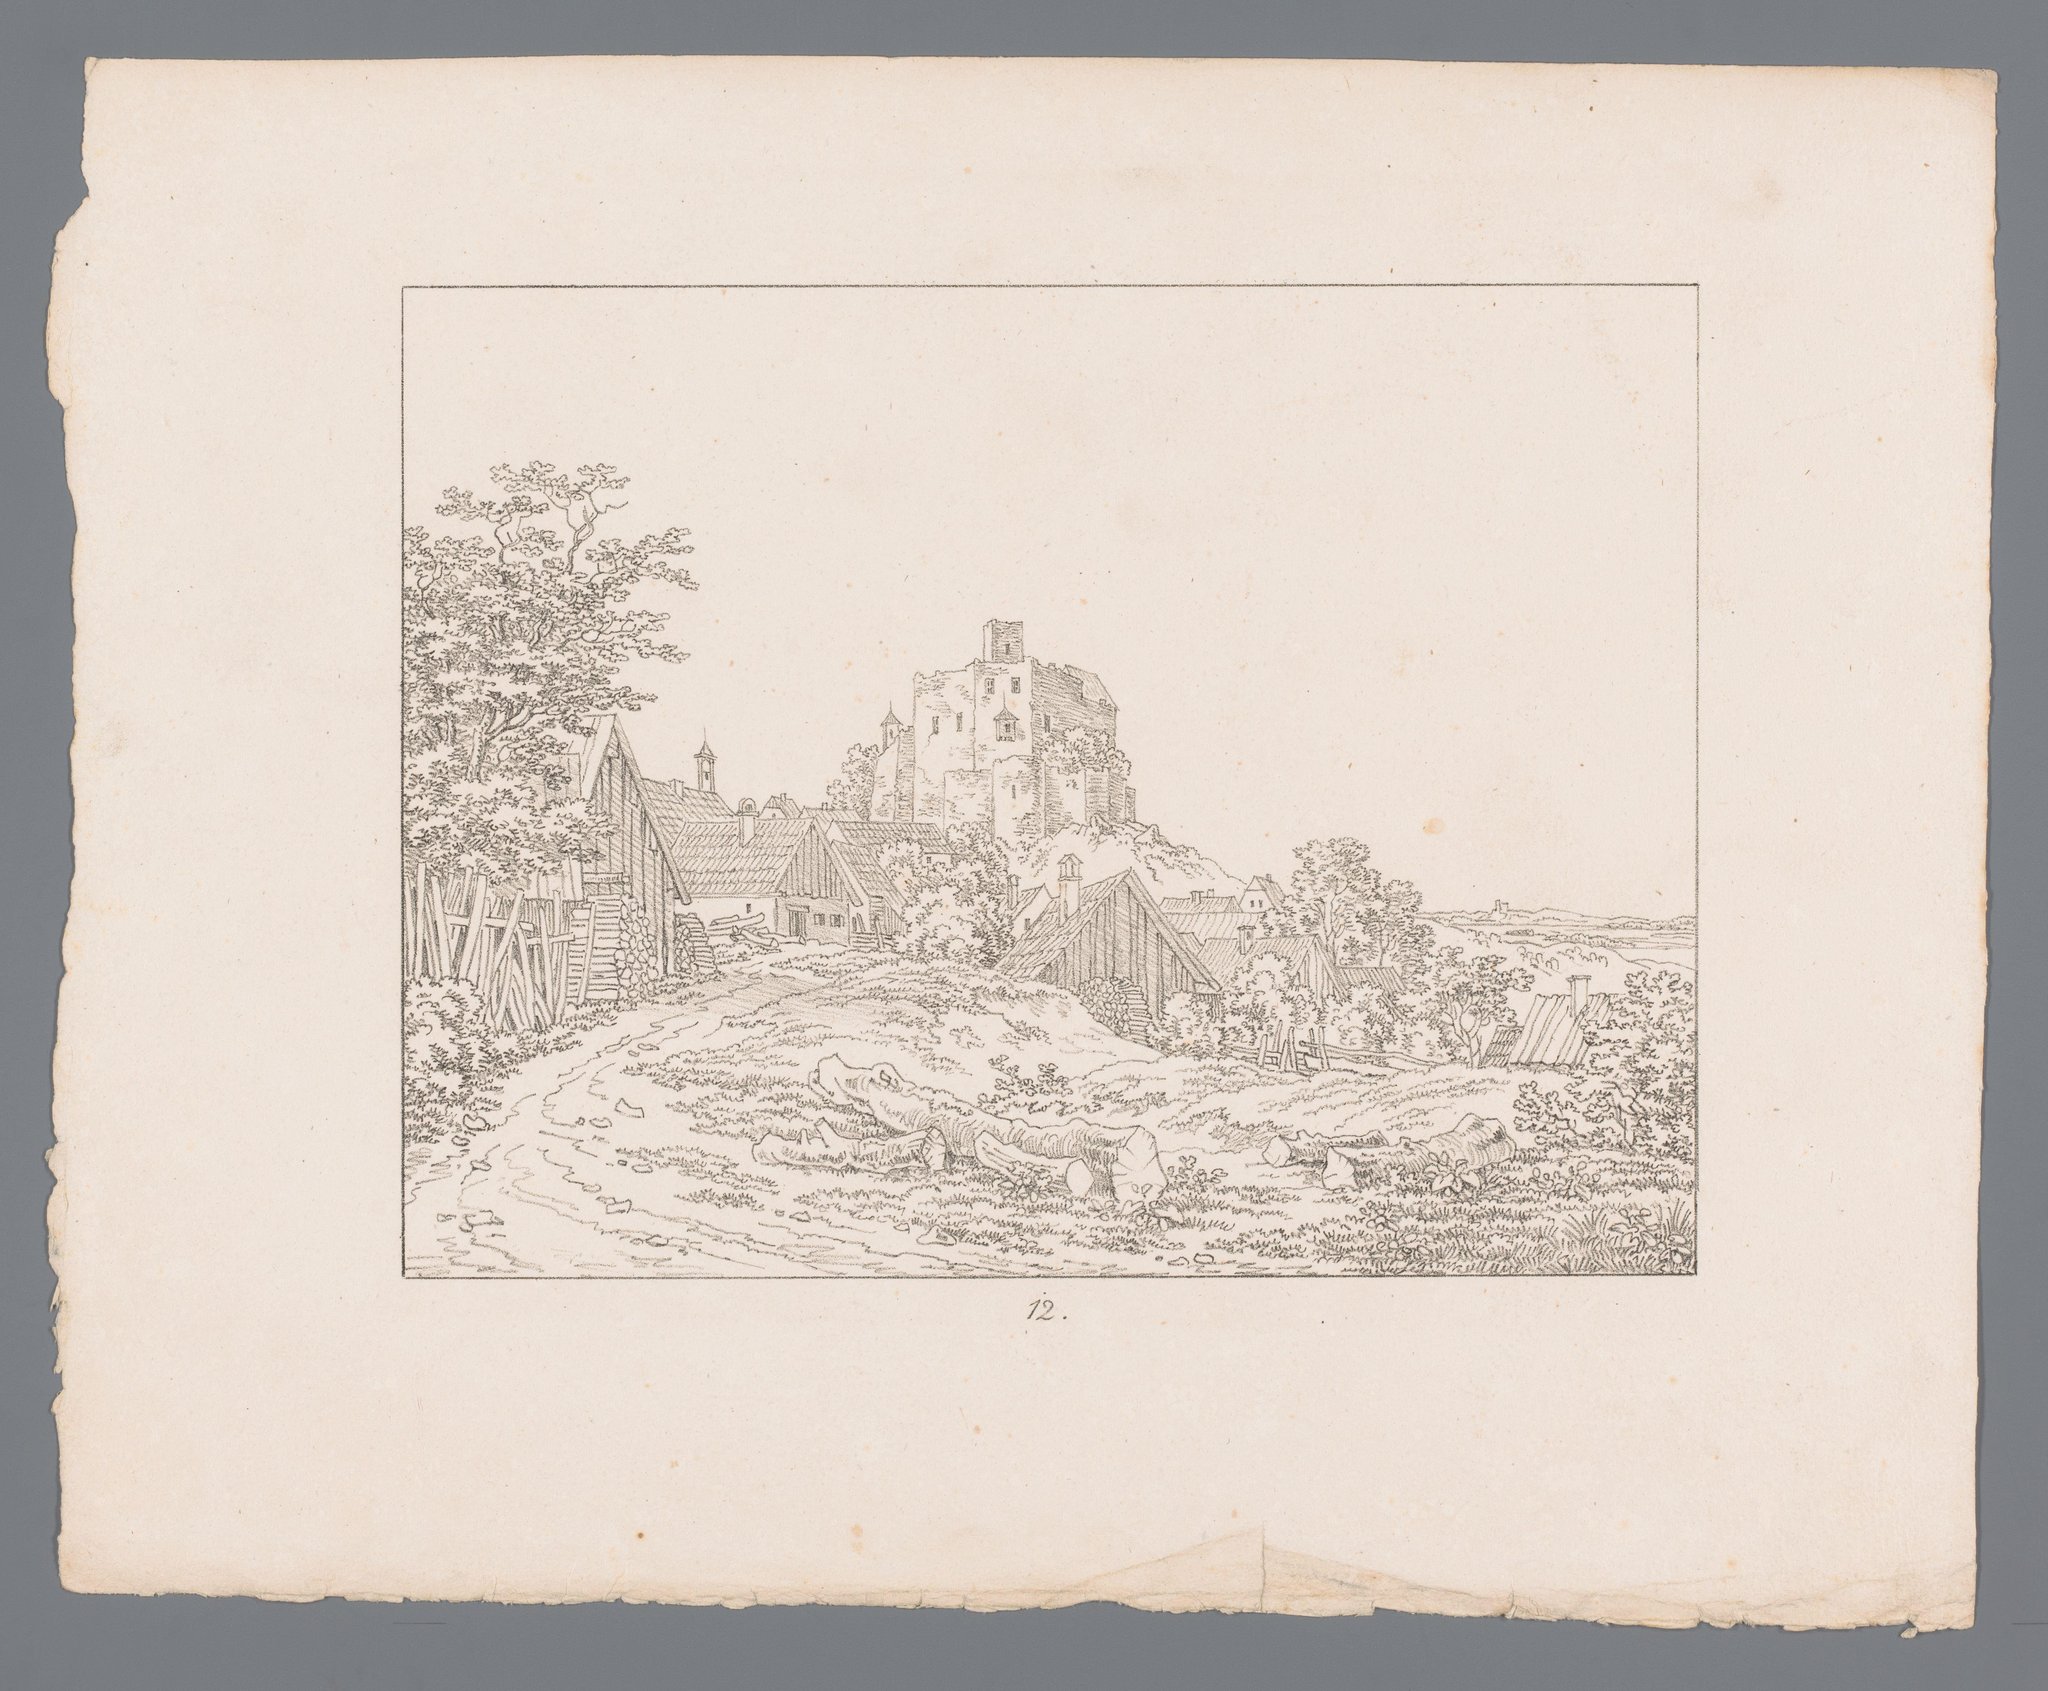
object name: print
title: Voorbeelden voor de landschapstekenaar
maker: max josef wagenbauer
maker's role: print maker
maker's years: 1774-1829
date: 1823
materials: paper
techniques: lithograph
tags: landscape with tower or castle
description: Onderdeel van een tweedelige serie waarvan het tweede deel bestaat uit een titelprent en twaalf voorstellingen van takken, bladeren, bomen en landschappen.